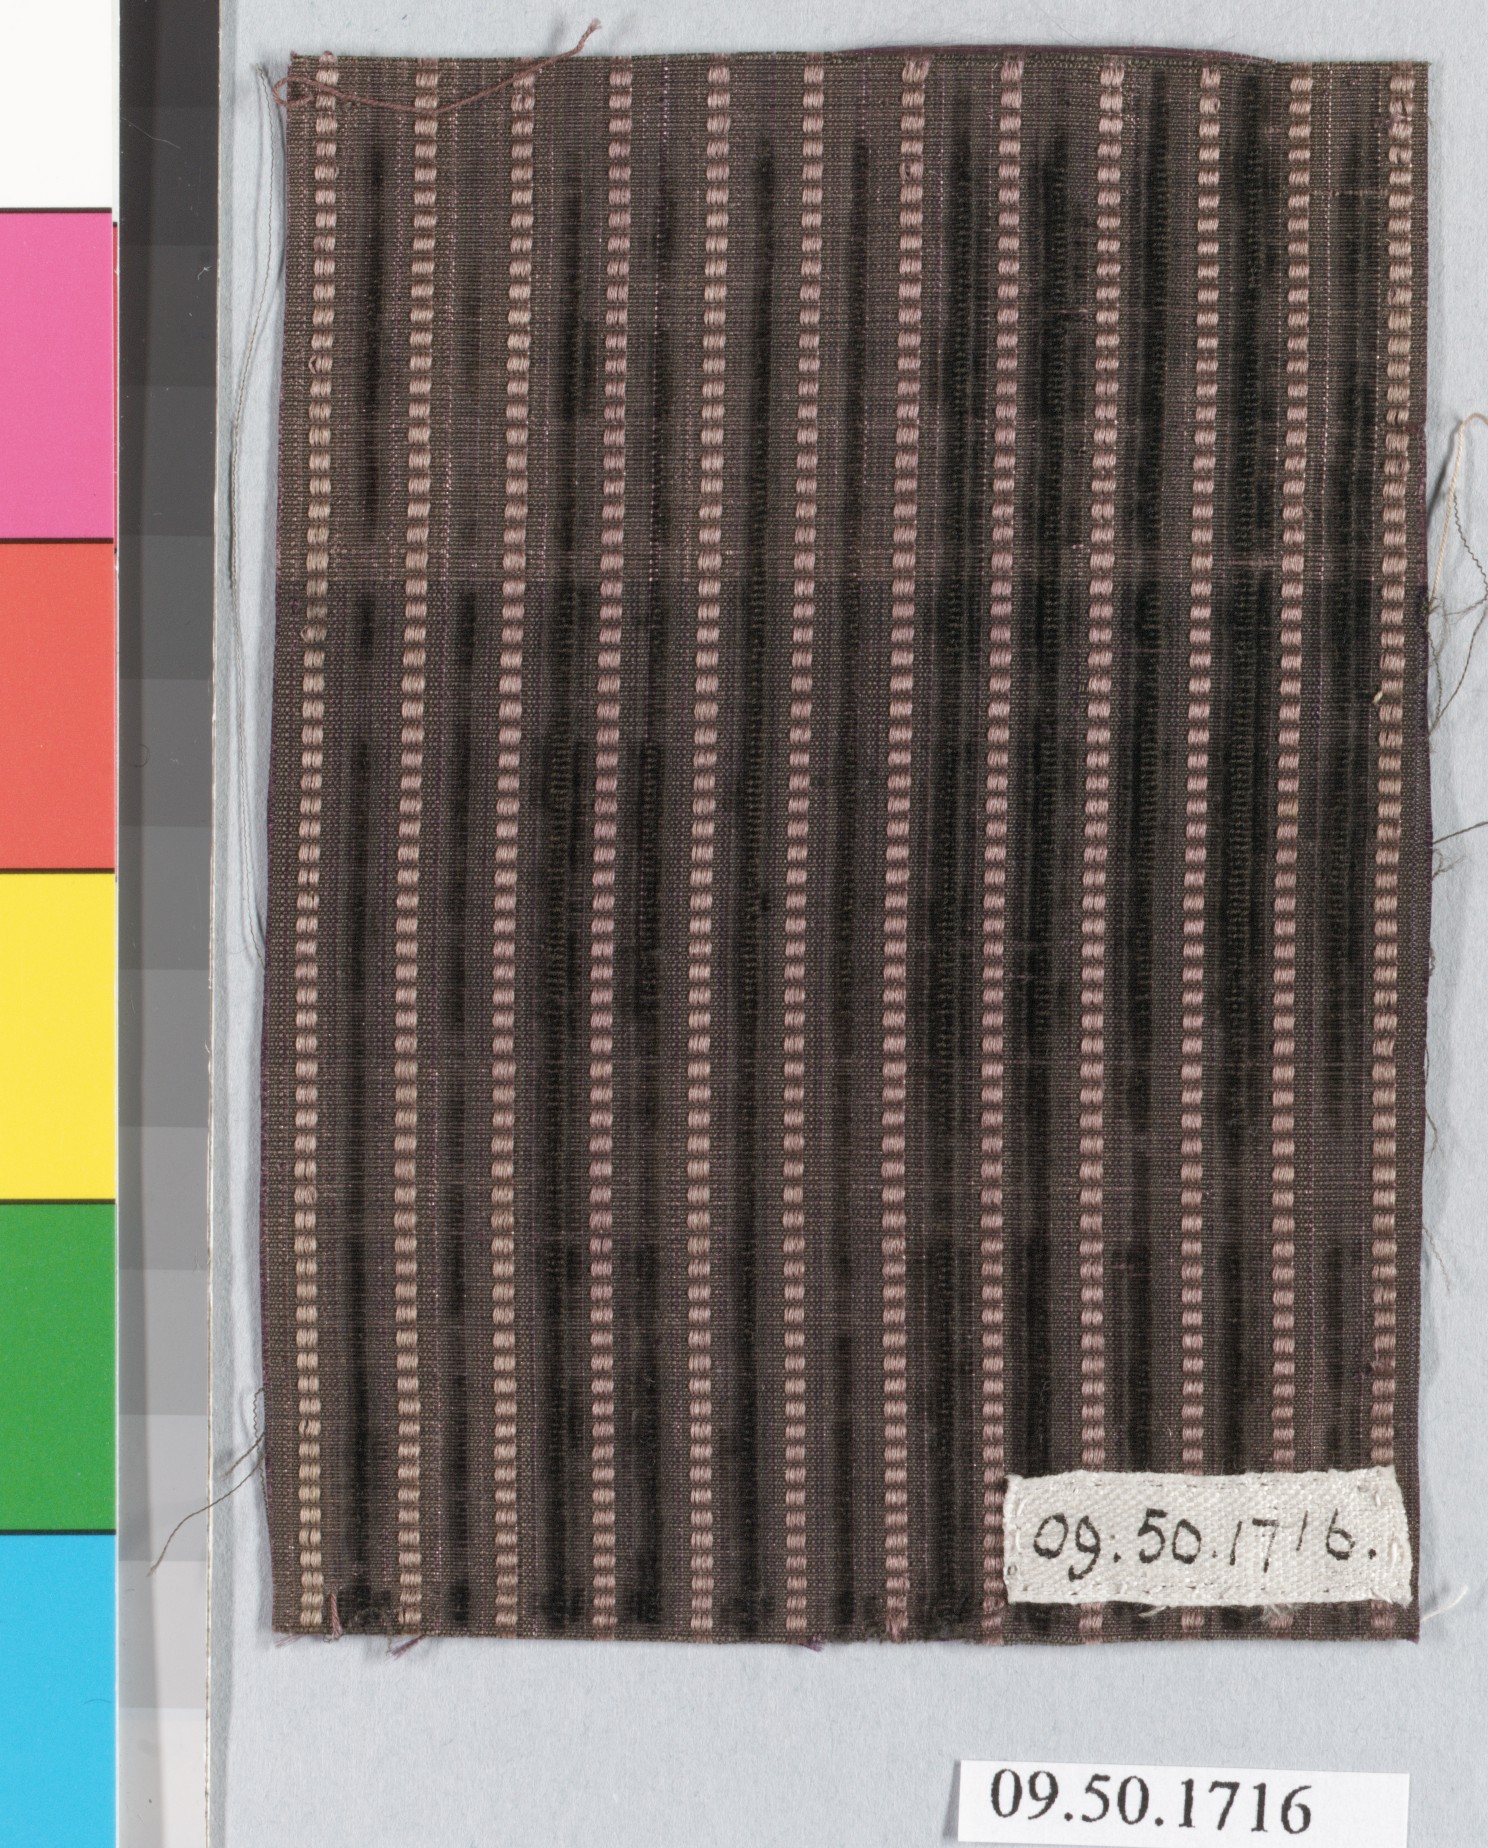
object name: piece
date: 1701-1800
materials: silk